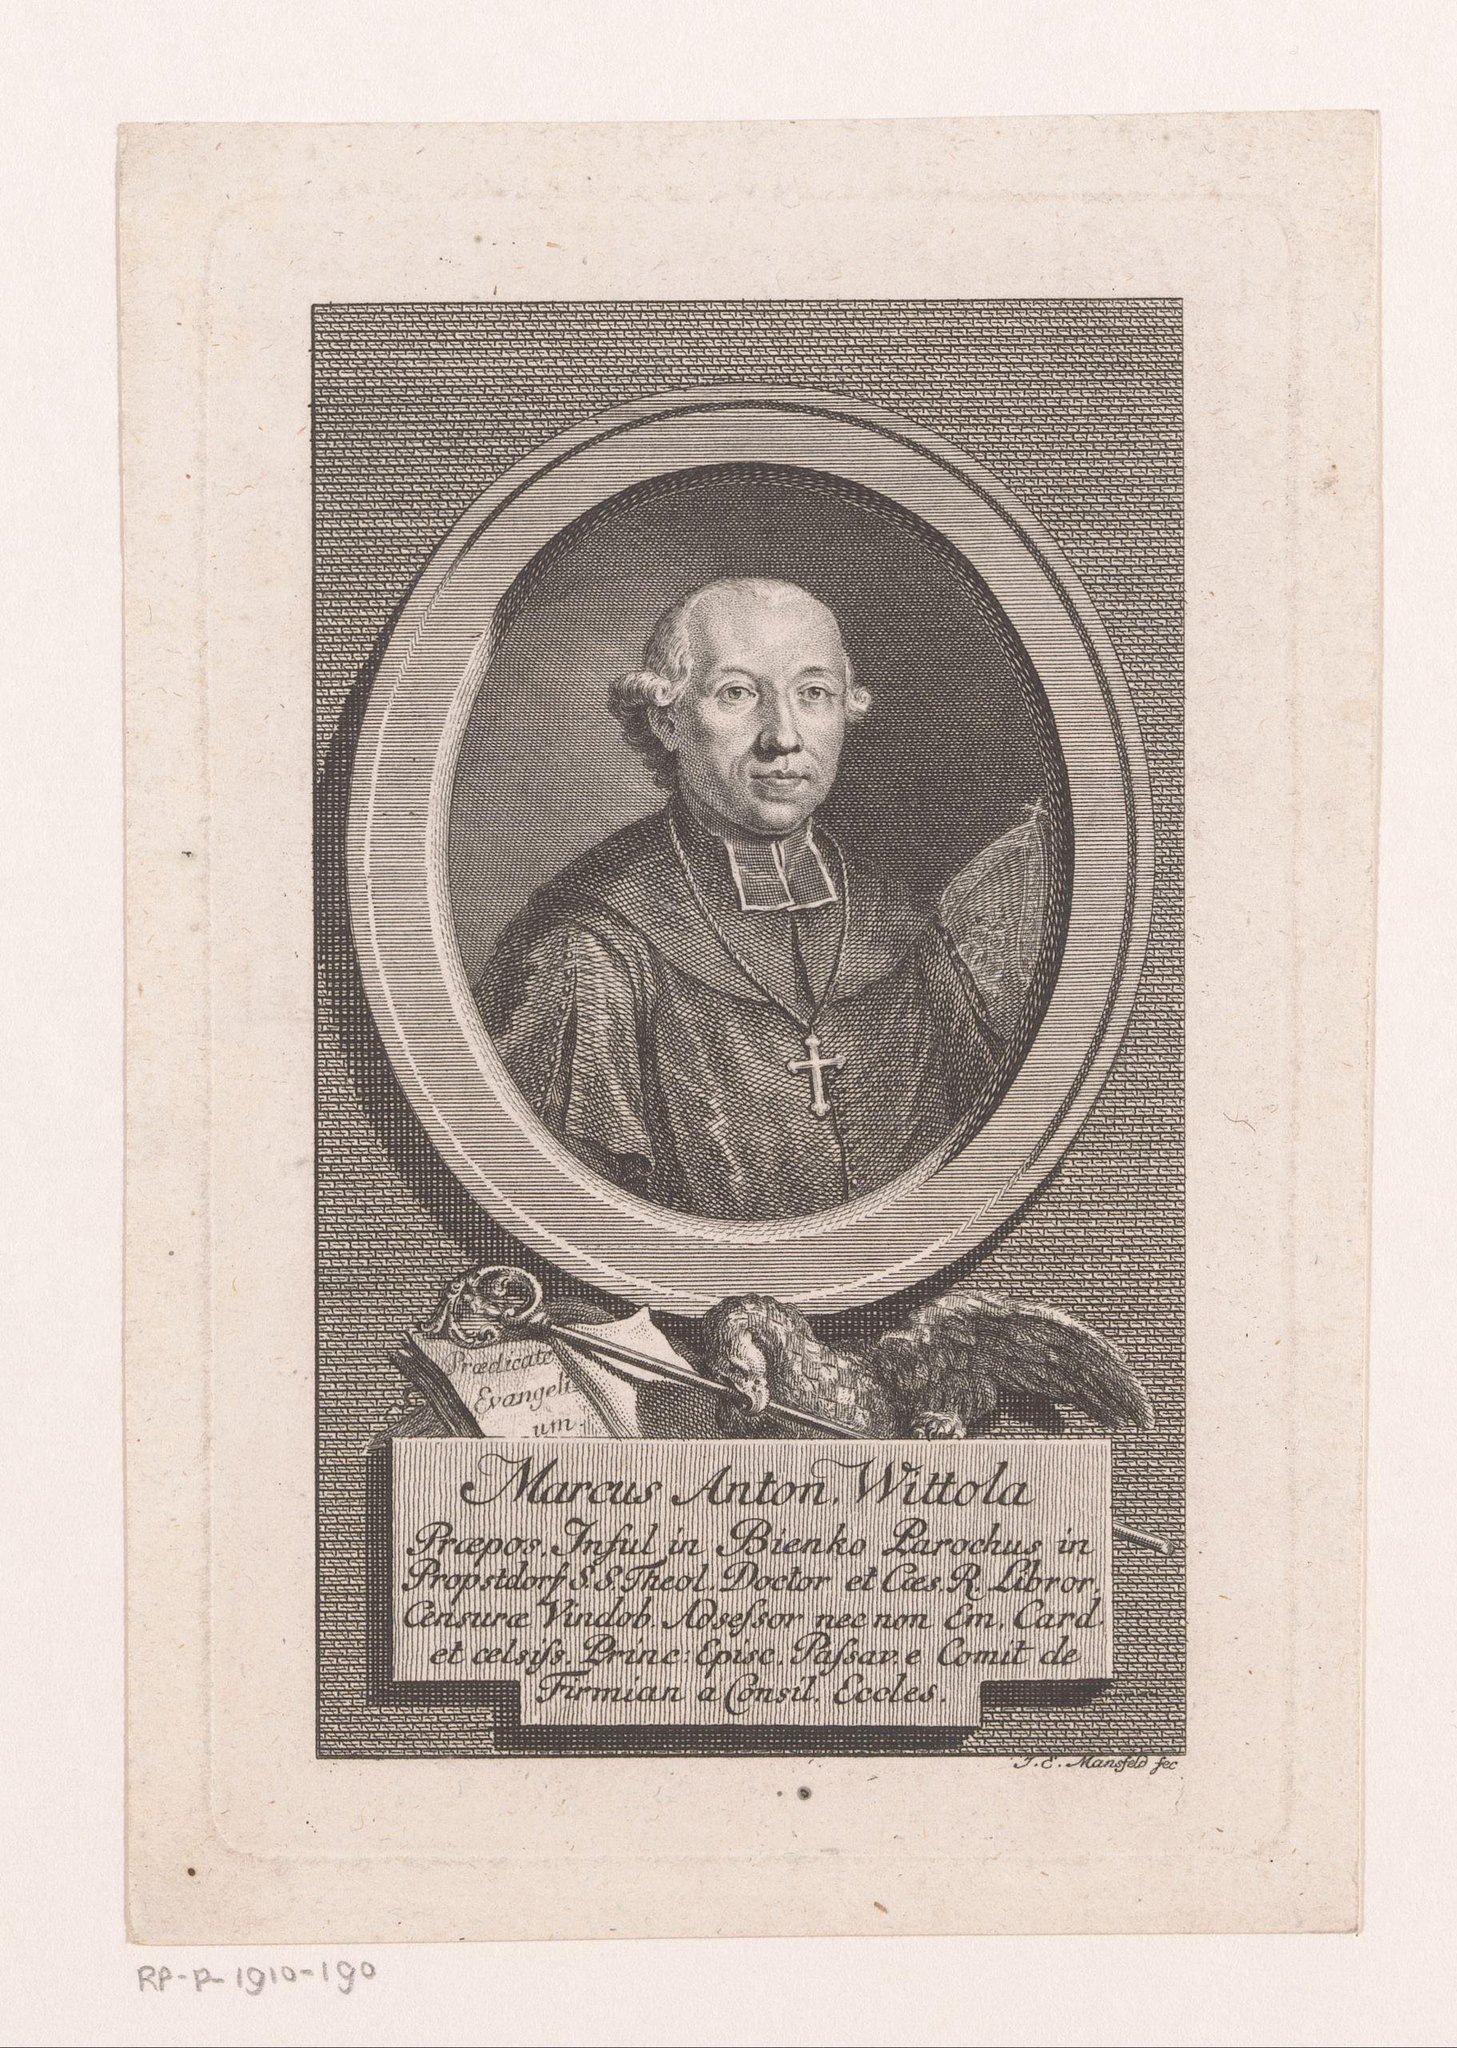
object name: print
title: Portret van Marcus Anton Wittola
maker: johann ernst mansfeld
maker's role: print maker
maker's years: 1739-1796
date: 1749-1796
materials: paper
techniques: engraving, etching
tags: historical persons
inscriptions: collector's mark: Lugt 2228